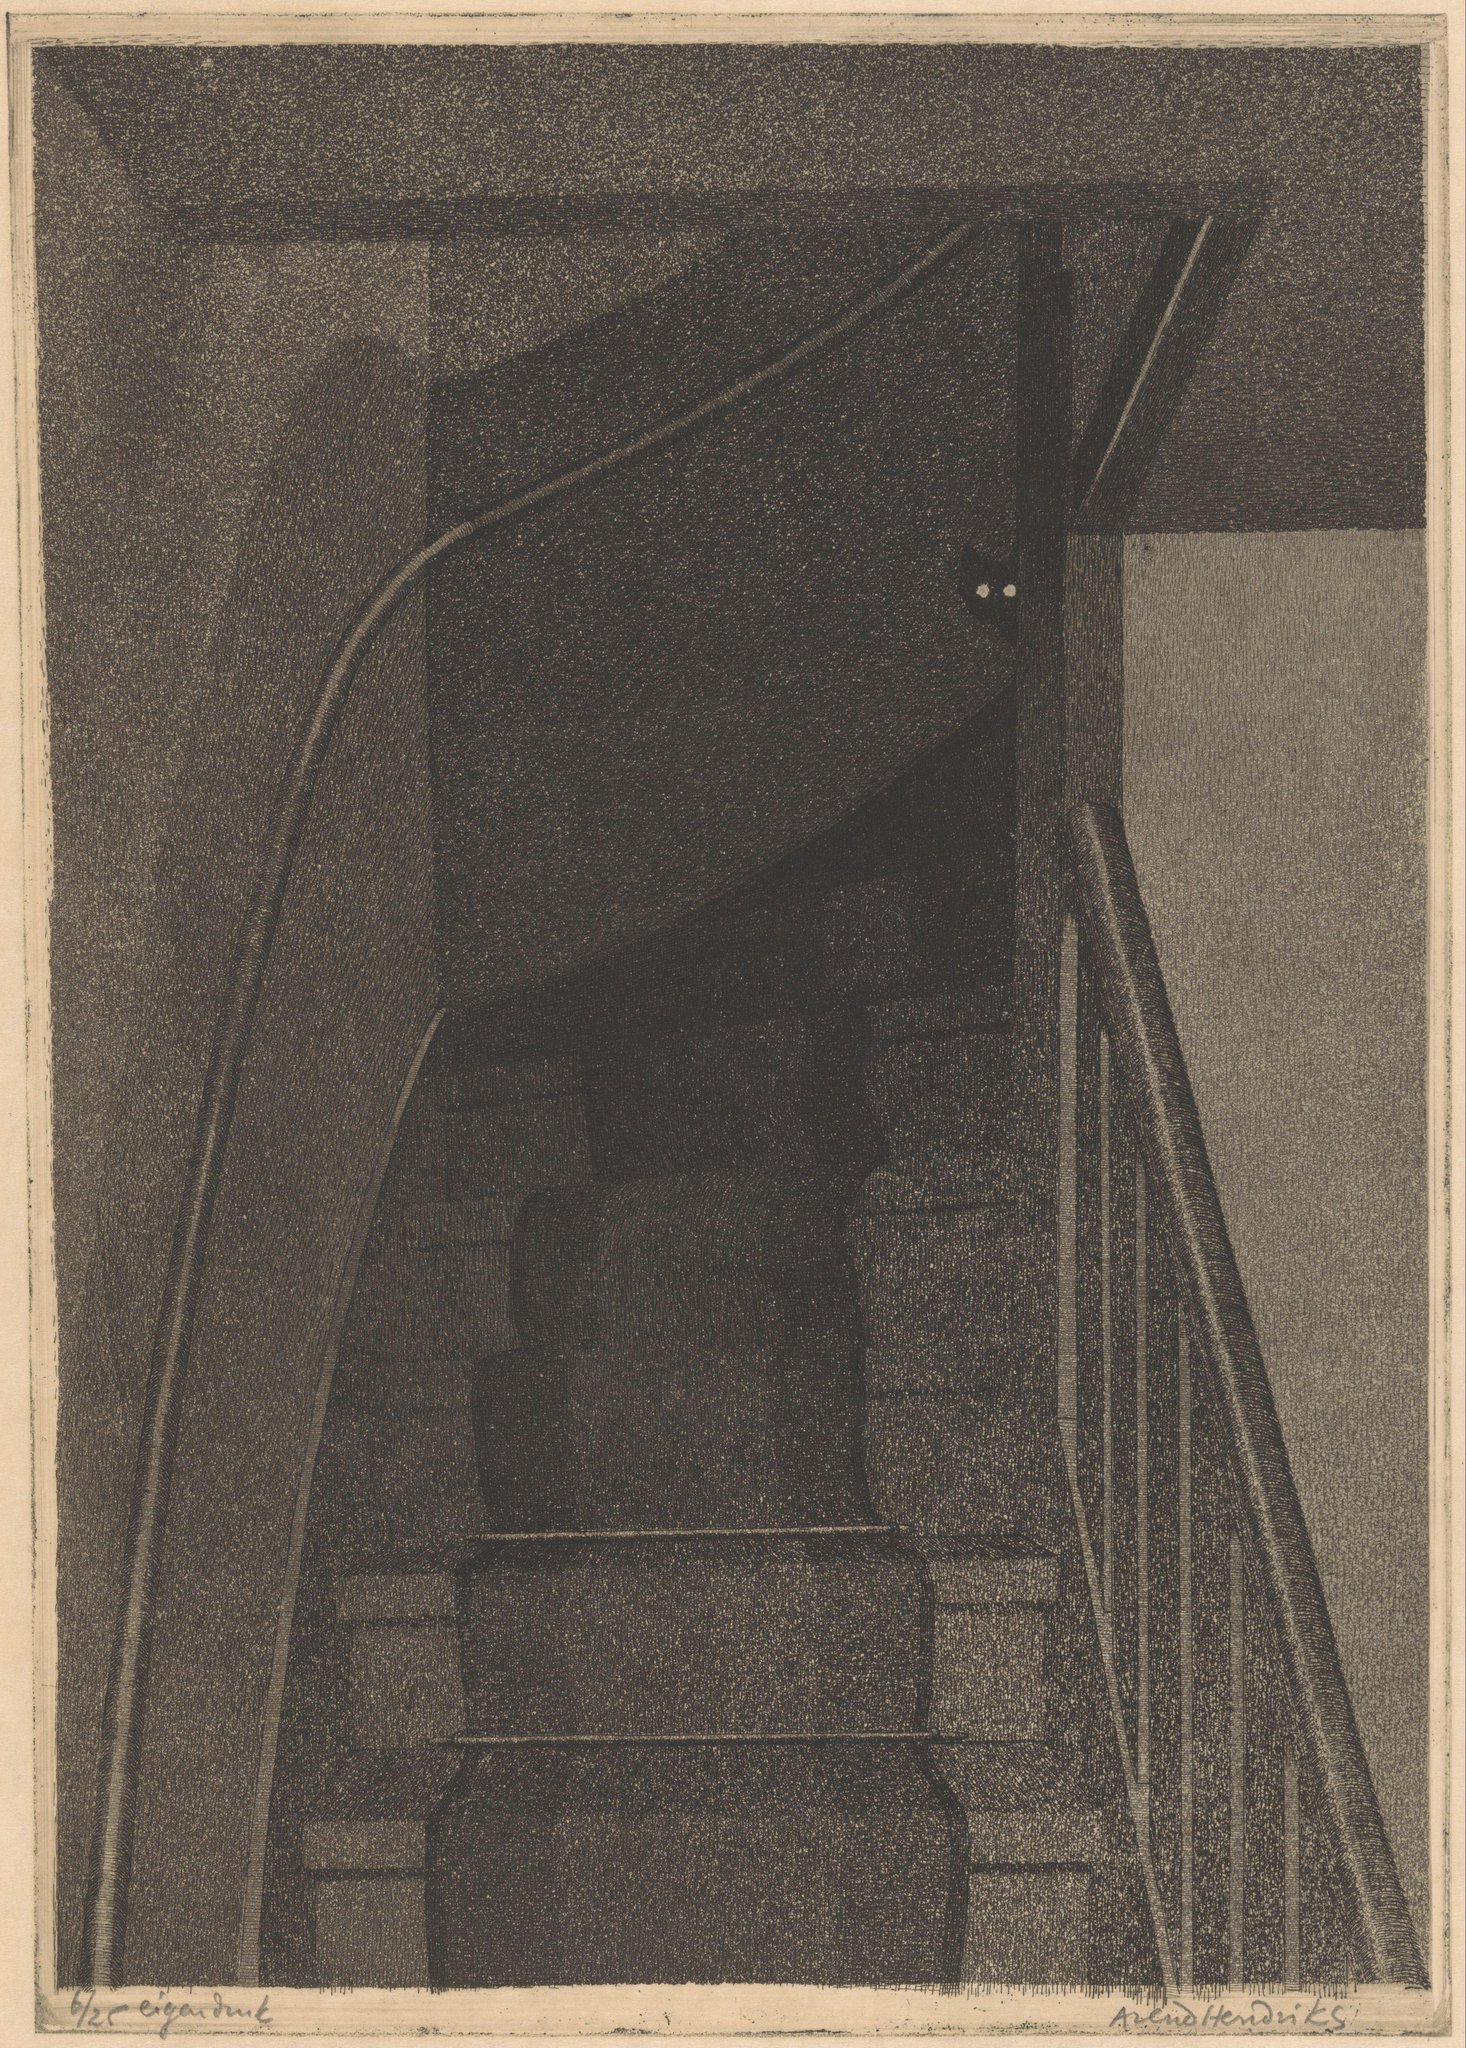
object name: print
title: Trap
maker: arend hendriks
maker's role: print maker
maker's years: 1901-1951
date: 1911-1943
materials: paper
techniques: aquatint, etching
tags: cat, staircase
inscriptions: collector's mark: Lugt 2228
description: Een trap met trapleuning. Bovenaan de trap een kat wiens ogen oplichten in het donker.